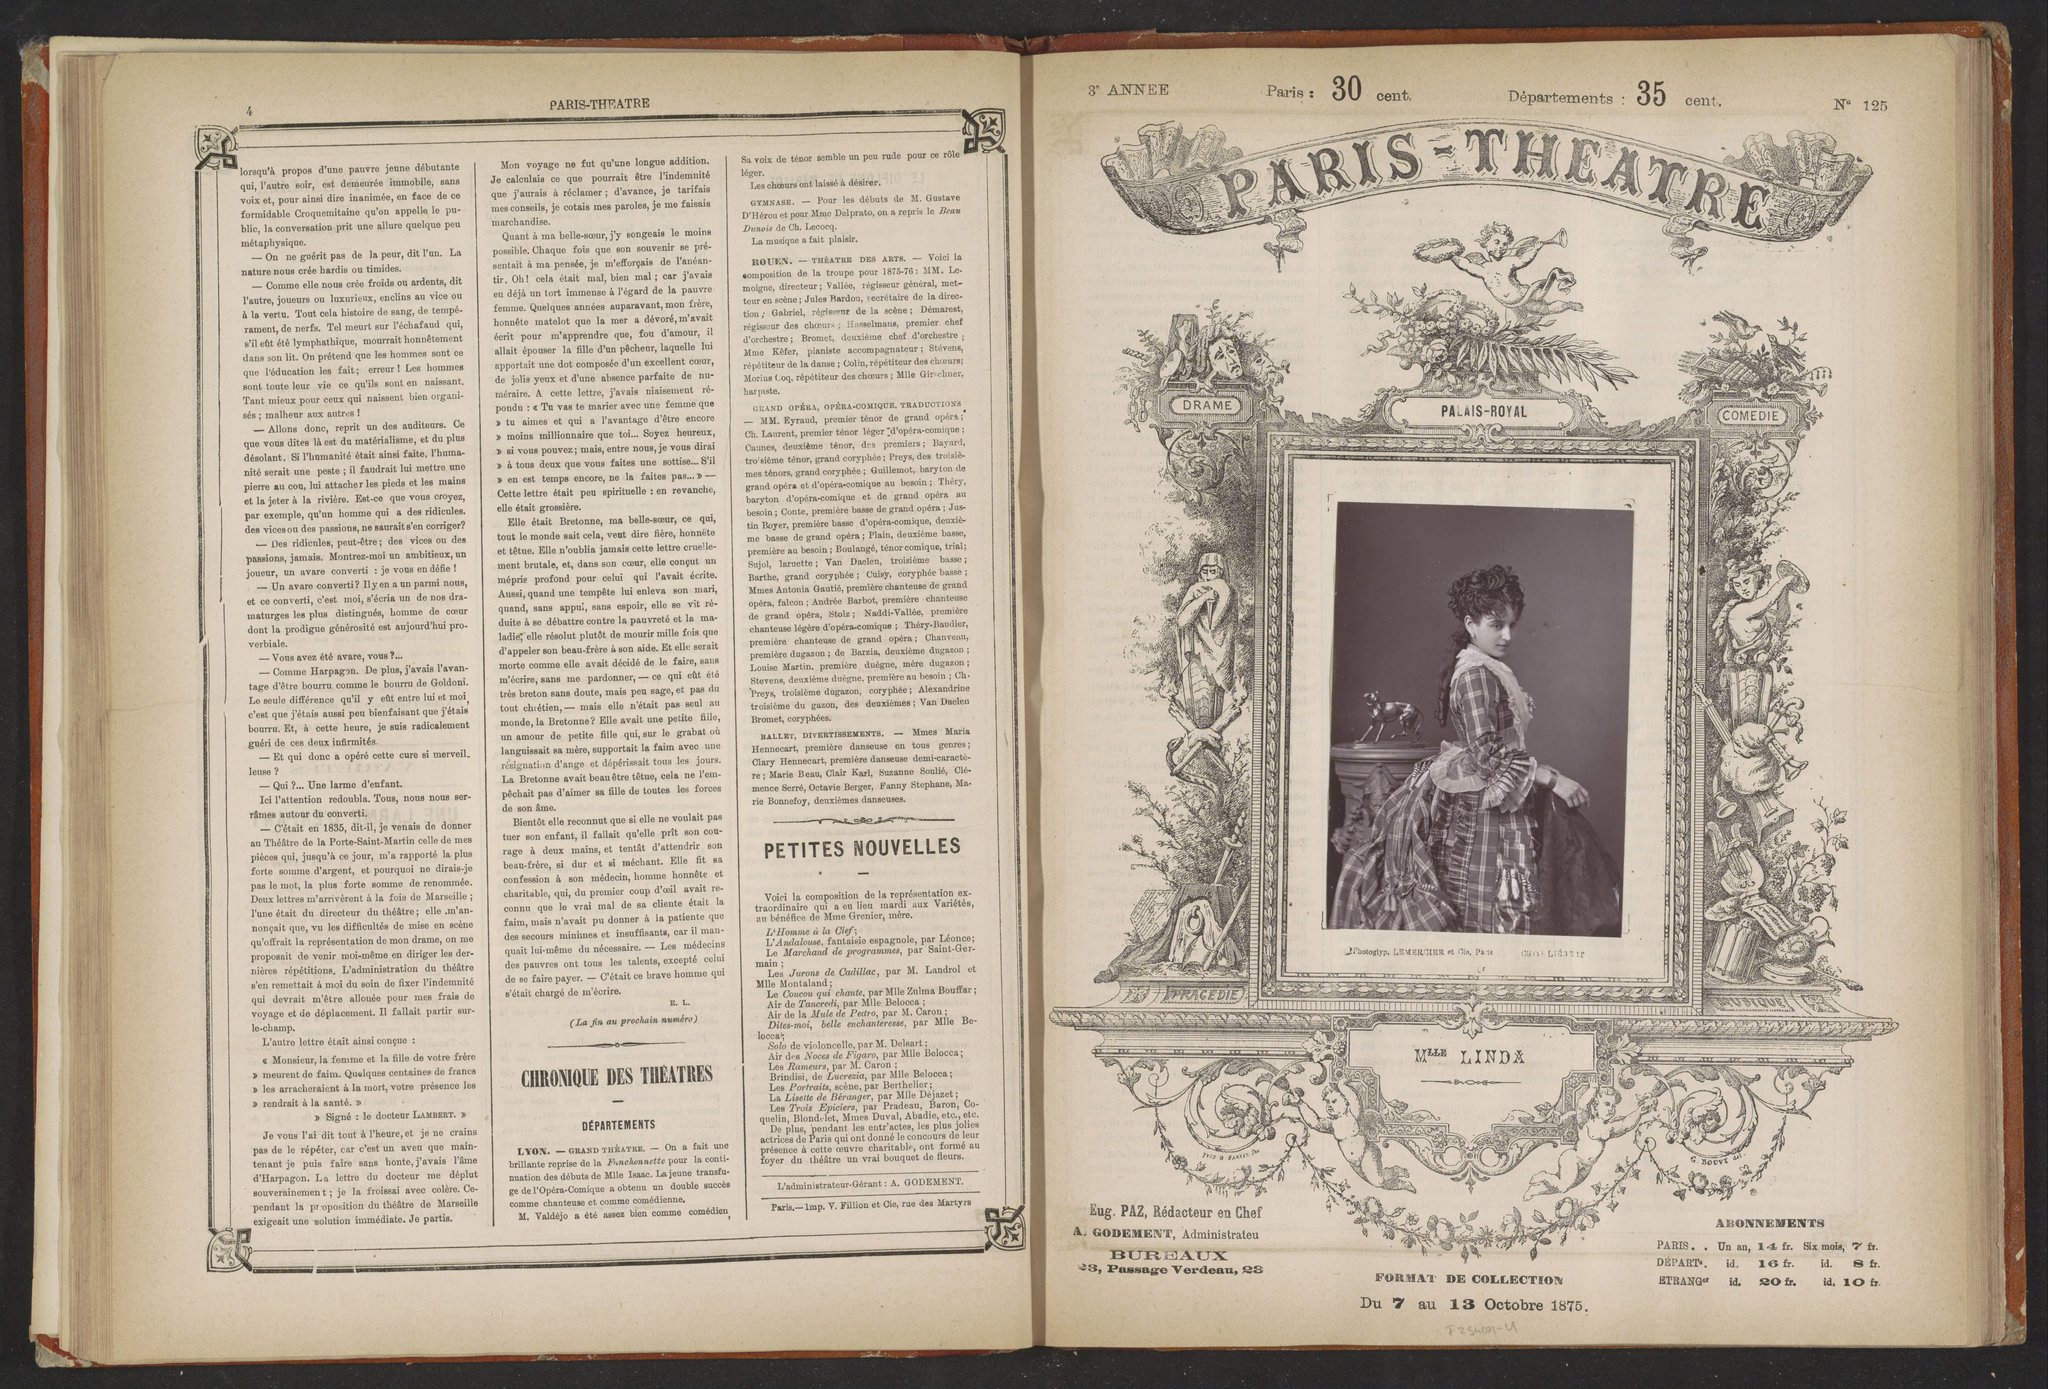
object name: page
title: Mlle Linda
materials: paper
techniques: woodburytype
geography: paris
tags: portrait of opera-singer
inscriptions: inscription: ‘Du 7 au 13 Octobre 1875’, number: ‘No 125’